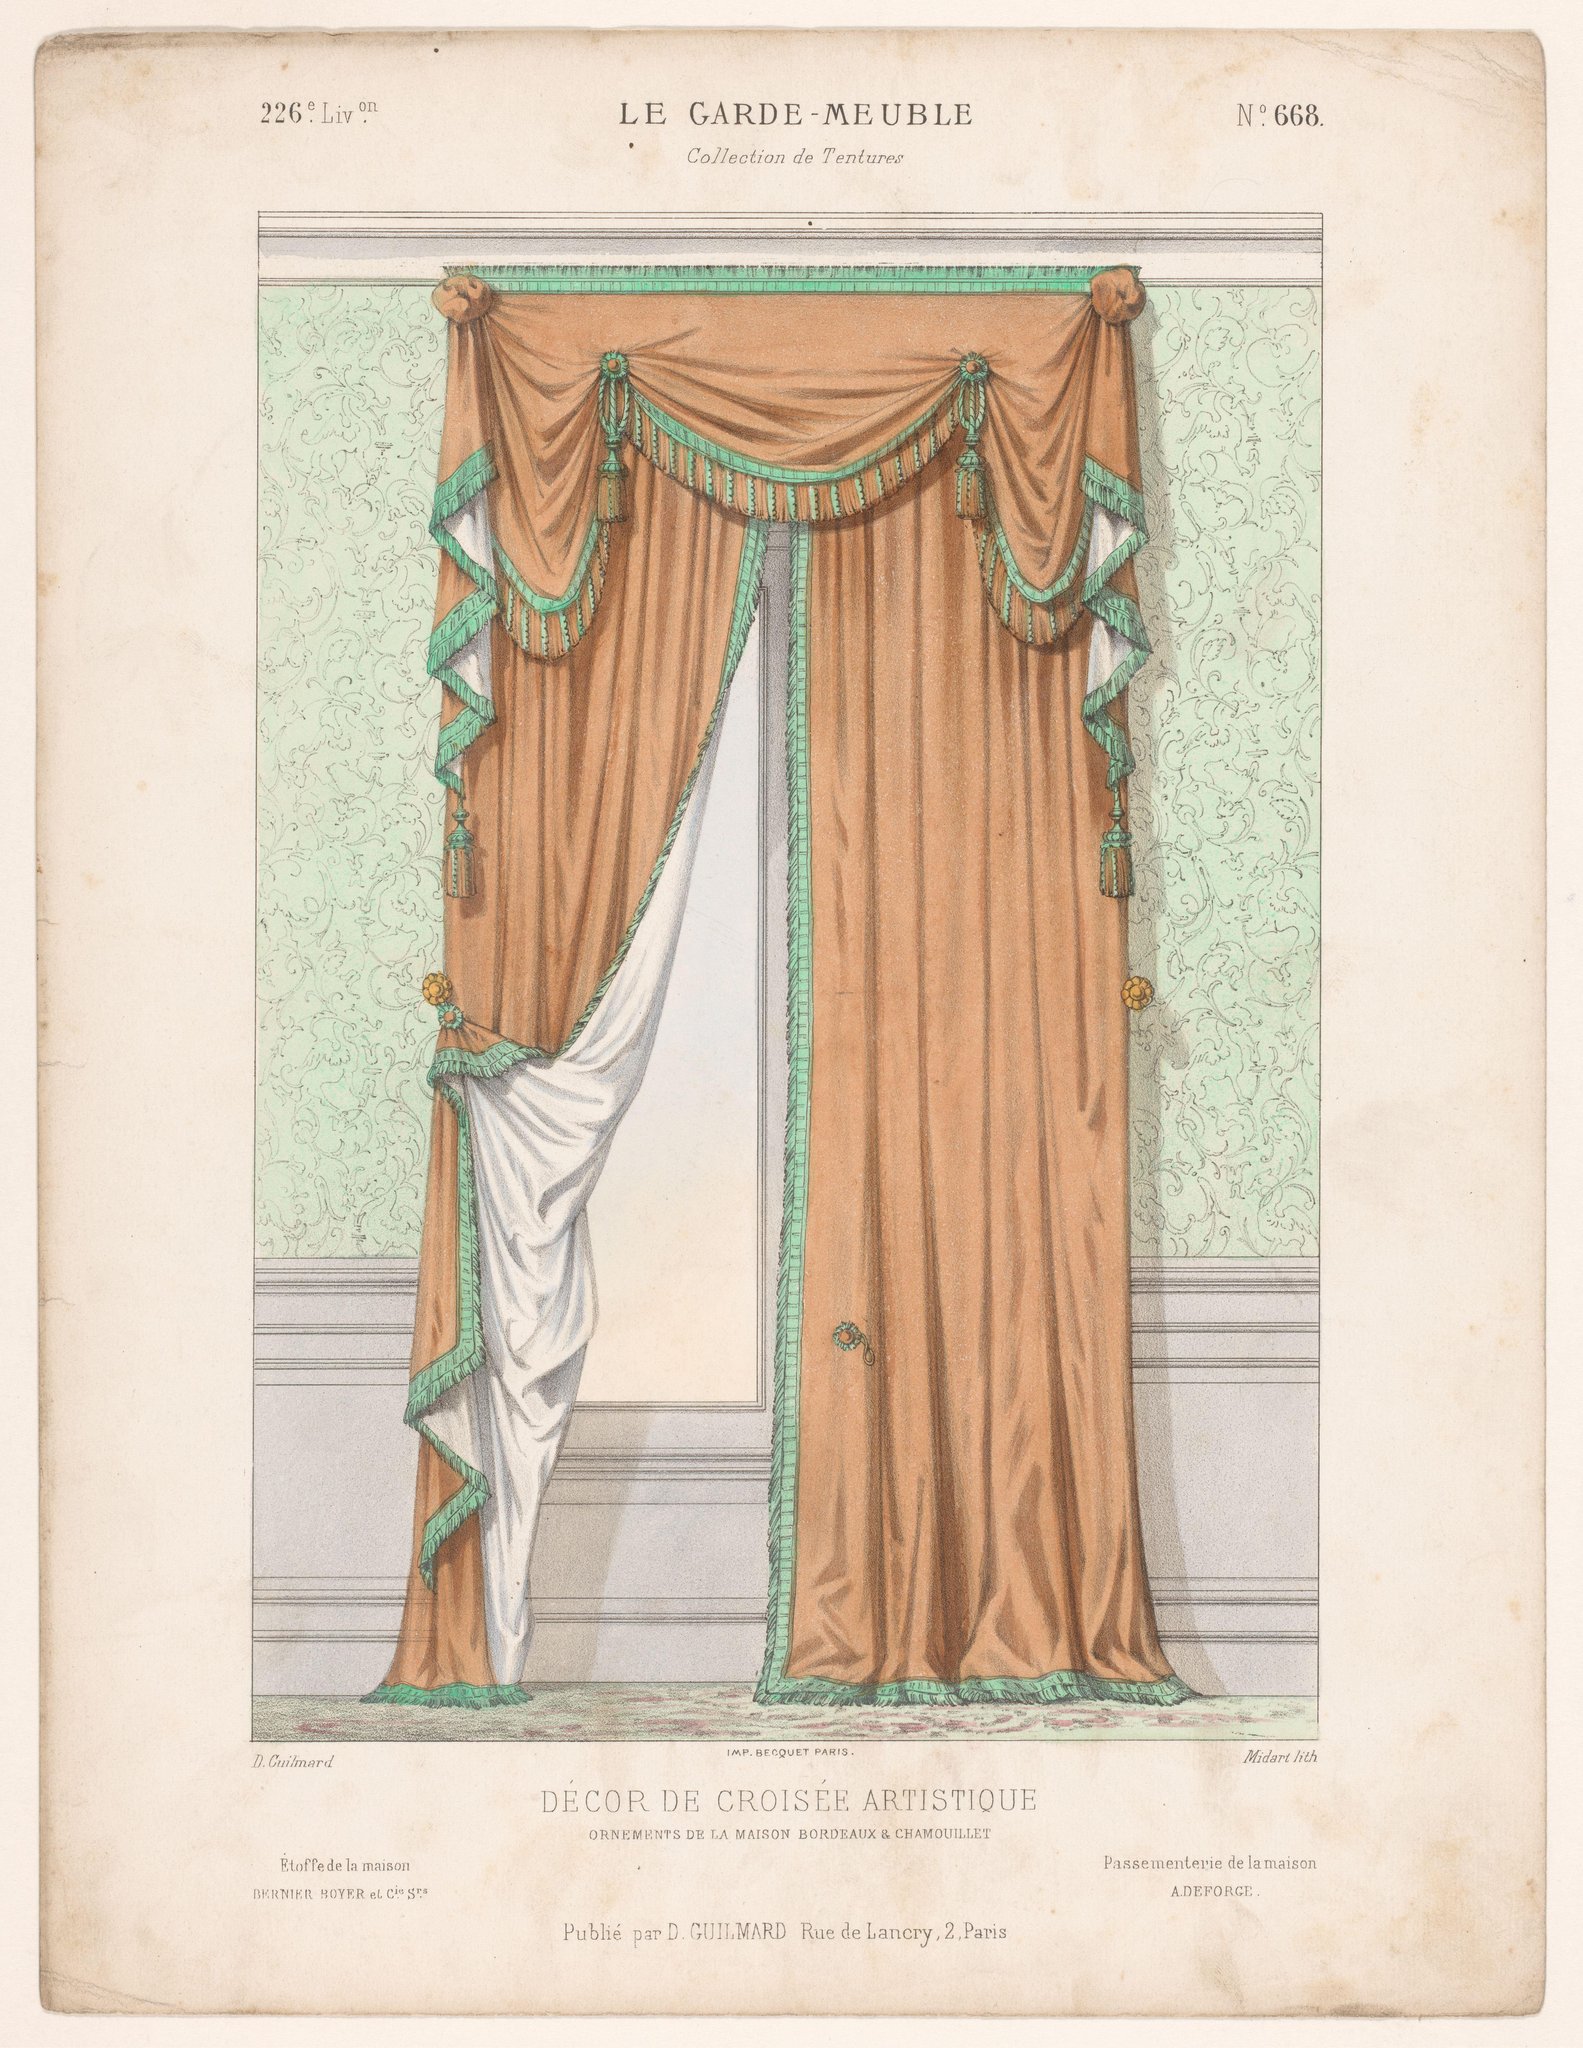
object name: print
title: Venster met gordijnen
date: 1860-1880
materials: paper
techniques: hand coloring, lithograph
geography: paris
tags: window, hangings and drapery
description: Kruisvenster met artistieke draperie. Prent uit 226e Livraison.